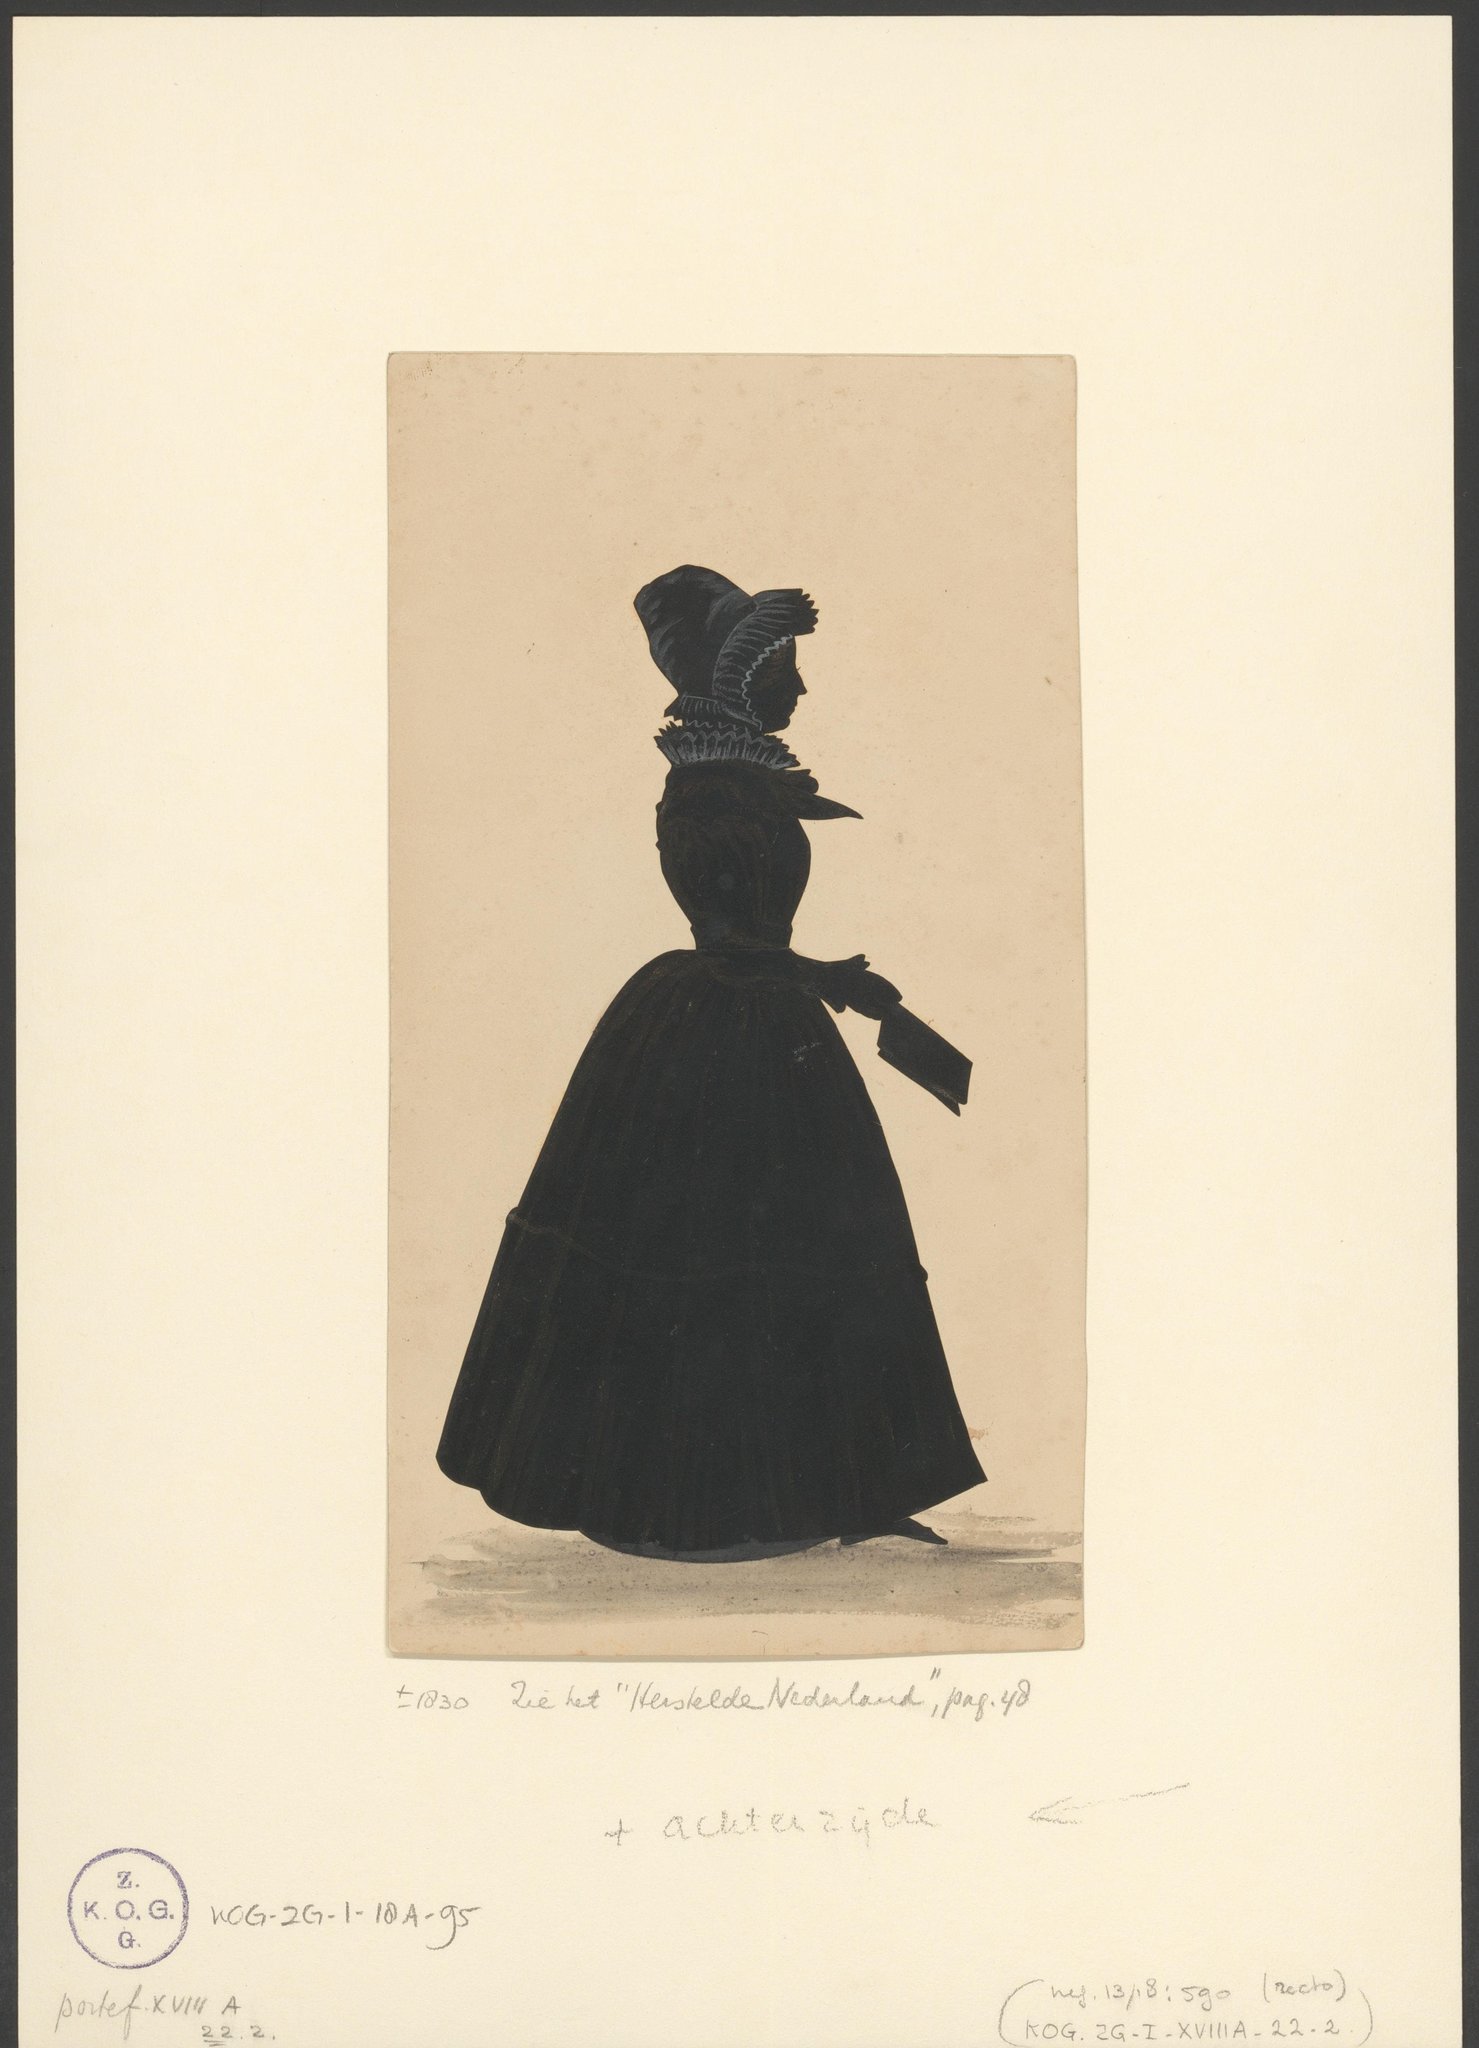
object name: drawing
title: Silhouetportret van een Margaretha Johanna Deutz van Assendelft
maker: edward s. haines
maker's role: knipkunstenaar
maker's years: 1801-1866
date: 1811-1866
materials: cardboard, ink, paint, paper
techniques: brush, snipping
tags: standing figure, historical persons - bb - woman, book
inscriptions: collector's mark: Lugt 1641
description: Onderwerpsrubrieken binnen de Atlas Zeden en Gewoonten: Schoone kunsten, Silhouetportretten.